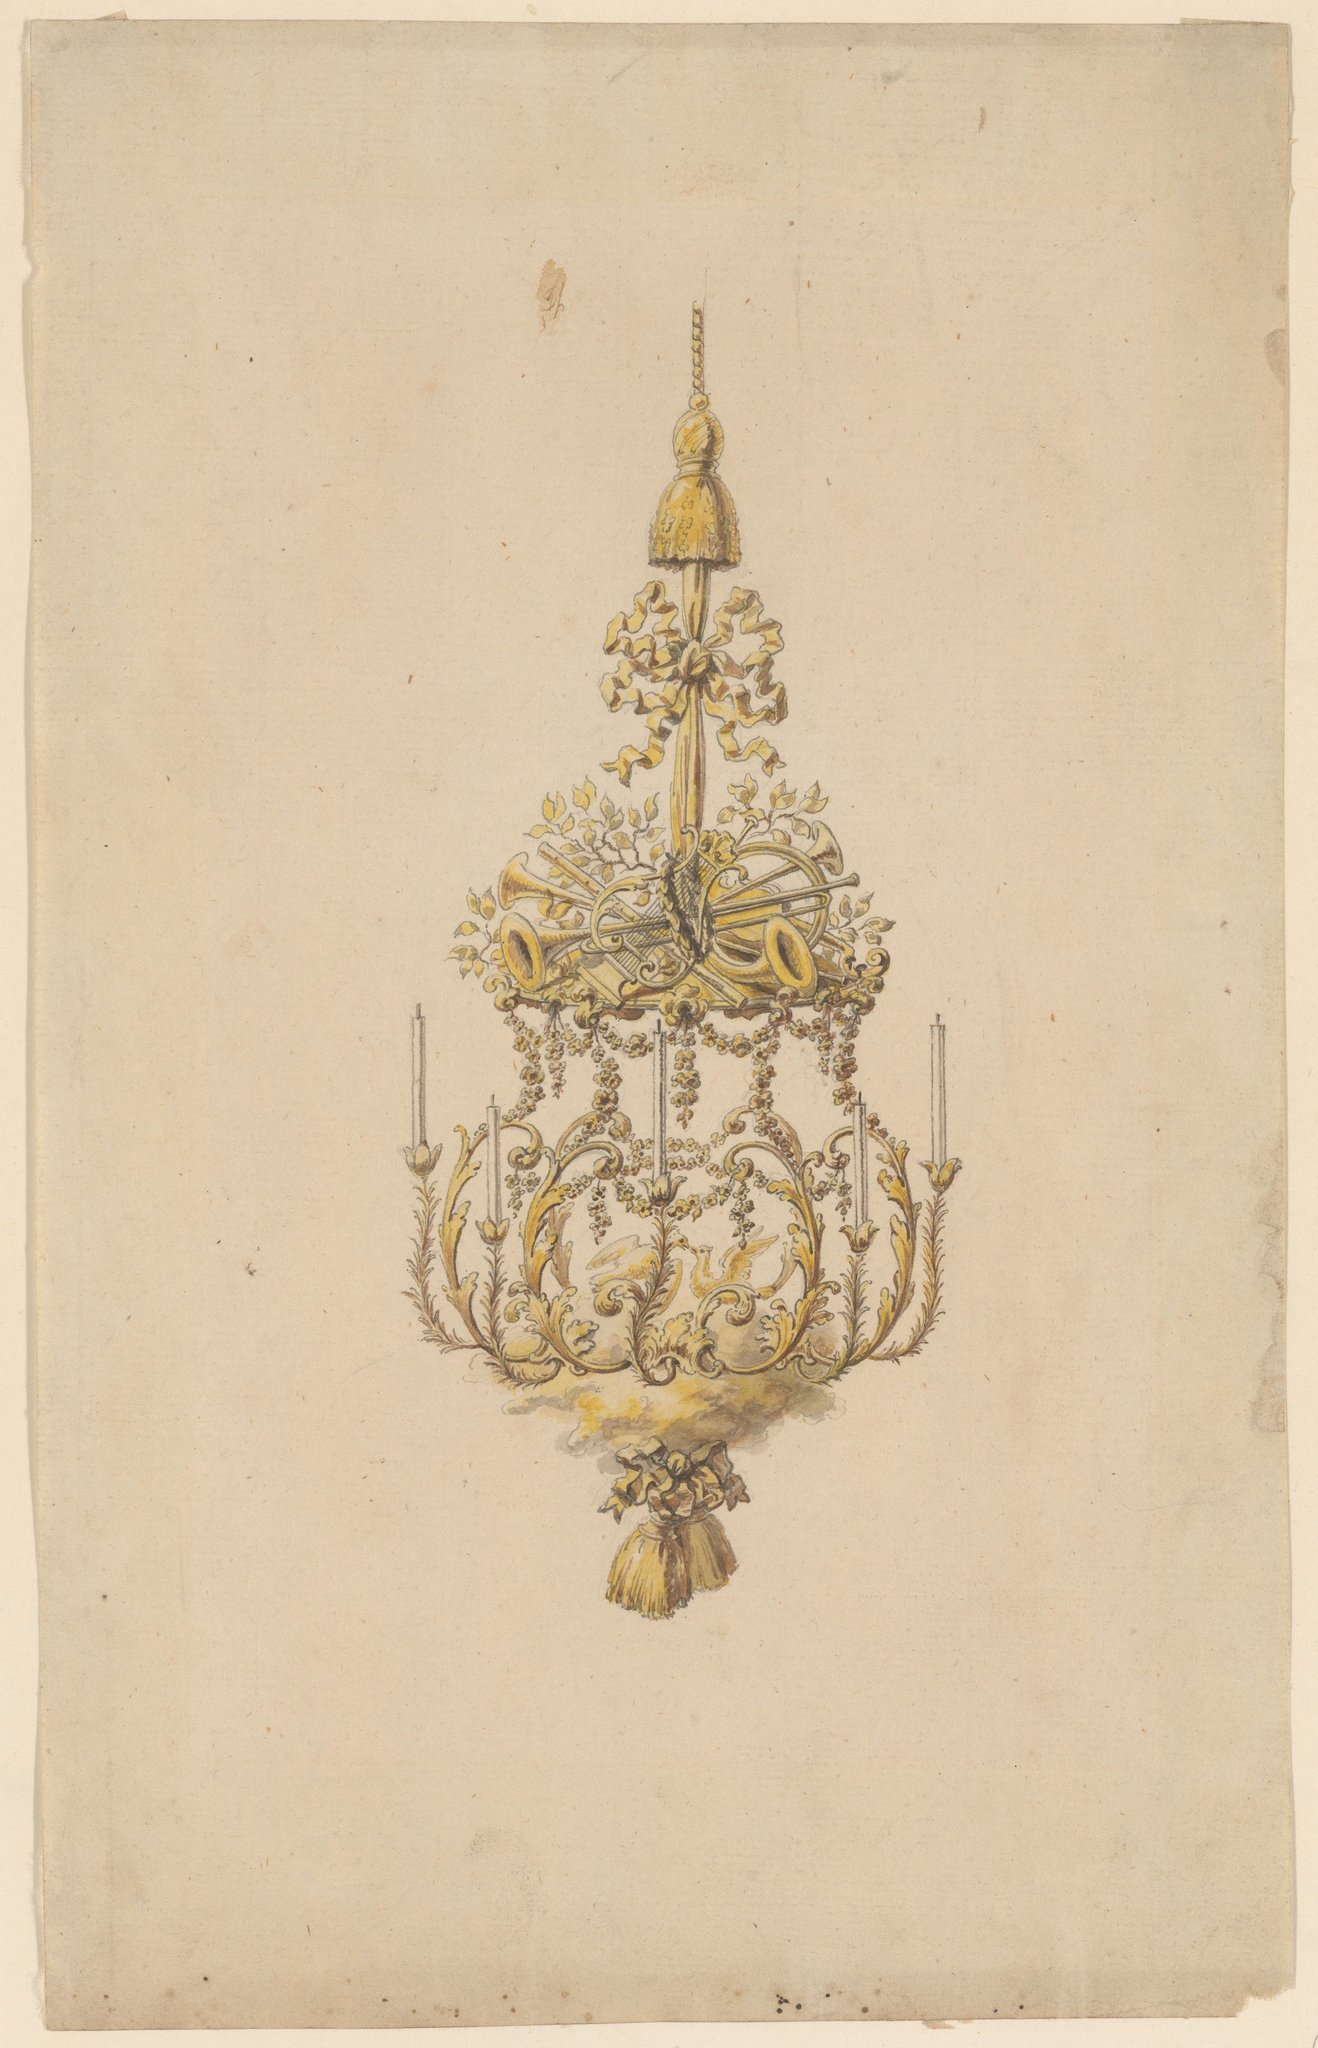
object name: drawing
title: Design for a chandelier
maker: anonymous, french, 18th century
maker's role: artist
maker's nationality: french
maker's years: 1700-1800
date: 1750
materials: ink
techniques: pen, wash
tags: chandelier